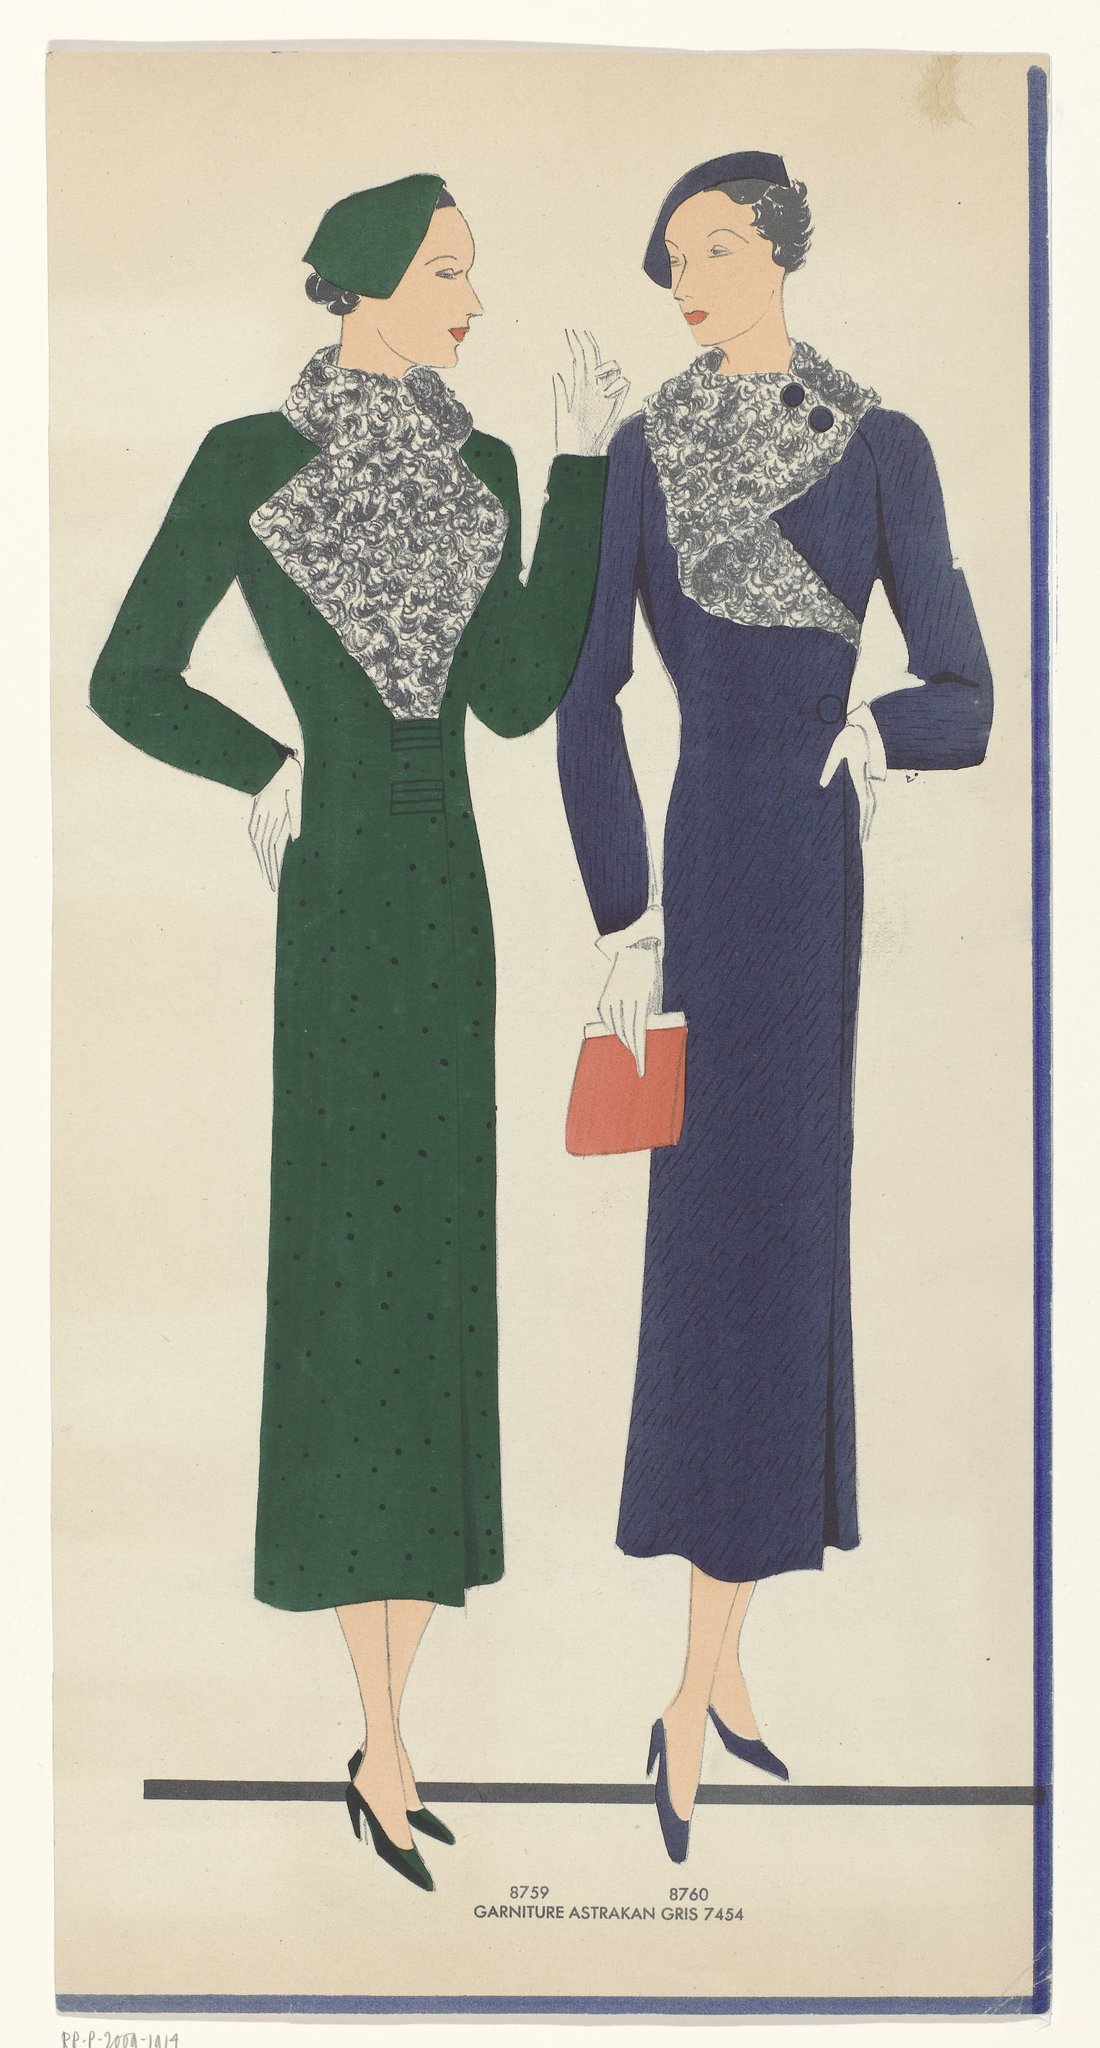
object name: fashion print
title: Vrouwen in jurken met garnering van astrakan, 1935, fig. 8757 t/m 8760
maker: Anonymous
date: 1935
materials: paper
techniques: hand coloring, lithograph, pochoir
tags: border, ribbon, braid (+ fur used for clothes), gloves, mittens (short gloves) (+ women's clothes), bag (clutch) (+ women's clothes), fashion plates, head-gear: hat (+ women's clothes), dress, gown (+ women's clothes)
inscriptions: caption: ‘8759 / 8760 / GARNITURE ASTRAKAN GRIS 7454’, caption: ‘8757 GARNITURE ASTRAKINETTE 7458 / 8758 GARNITURE ASTRAKAN GRIS 7454’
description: Recto: twee vrouwen, genummerd 8759 en 8760, in een donkergroene en donkerblauwe jurk, beiden met garnering (kraag?) van grijze astrakan (7454). Accessoires:hoeden, korte handschoenen, handtas, pumps. Verso: twee vrouwen, genummerd 8757 en 8758, in een grijs gestreepte jurk met 'garniture astrakinette' (7458) en een bruin gestreepte jurk met garnering van gijze astrakan (7454). De modeprent komt uit een catalogus.